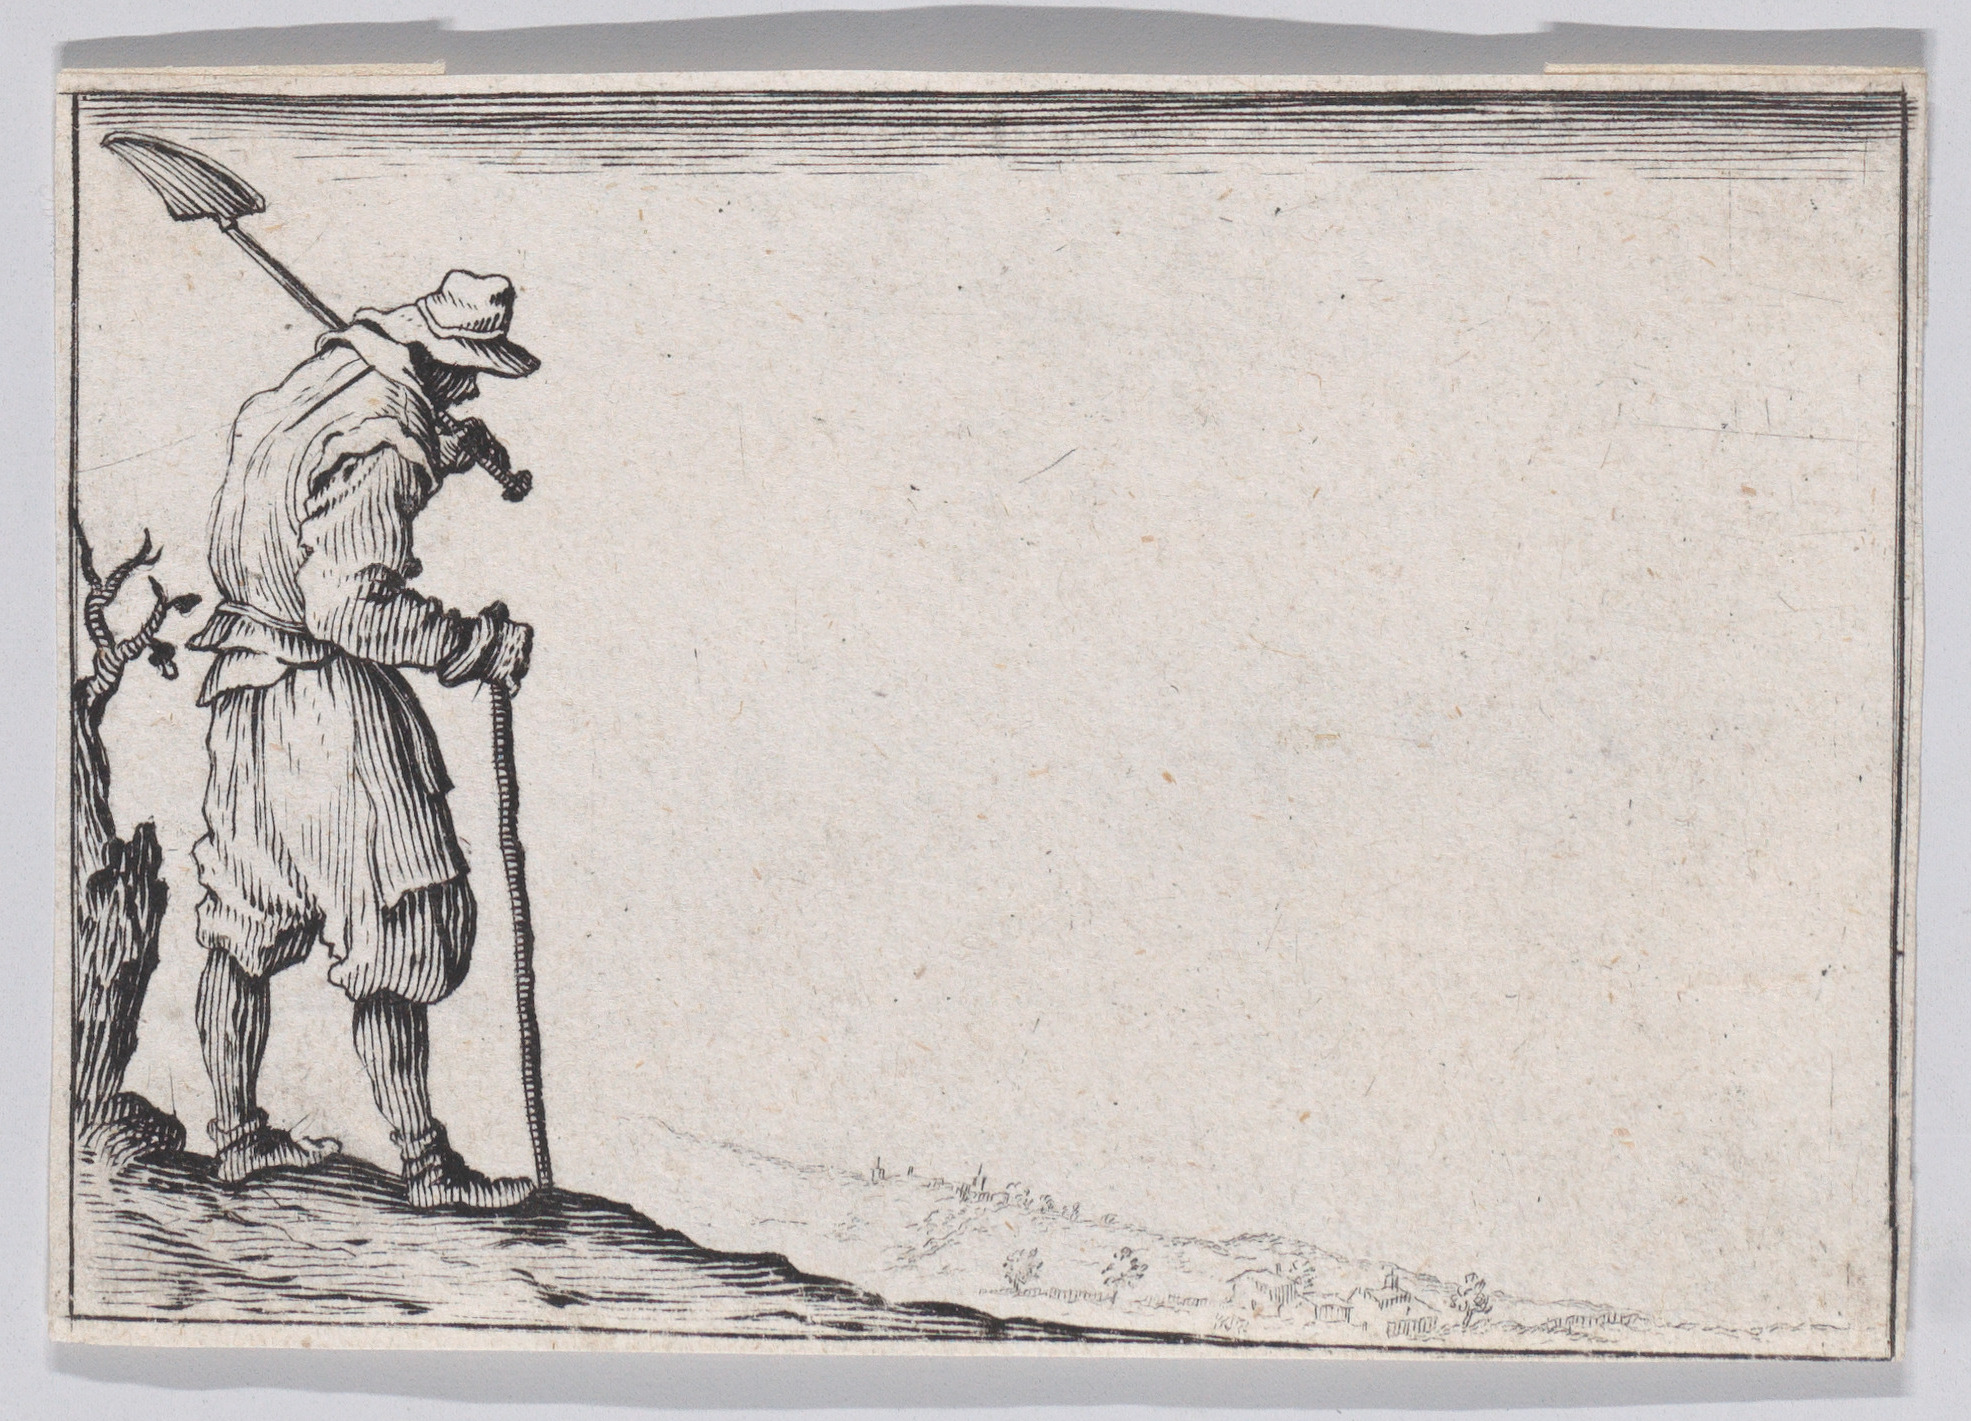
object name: print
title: Reverse Copy of Le Paysan Portant sa Pelle sur L'Épaule (The Peasant Carrying his Shovel over his Shoulder), from "Les Caprices" Series A, The Florence Set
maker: Anonymous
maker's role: artist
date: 1601-1700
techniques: etching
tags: men